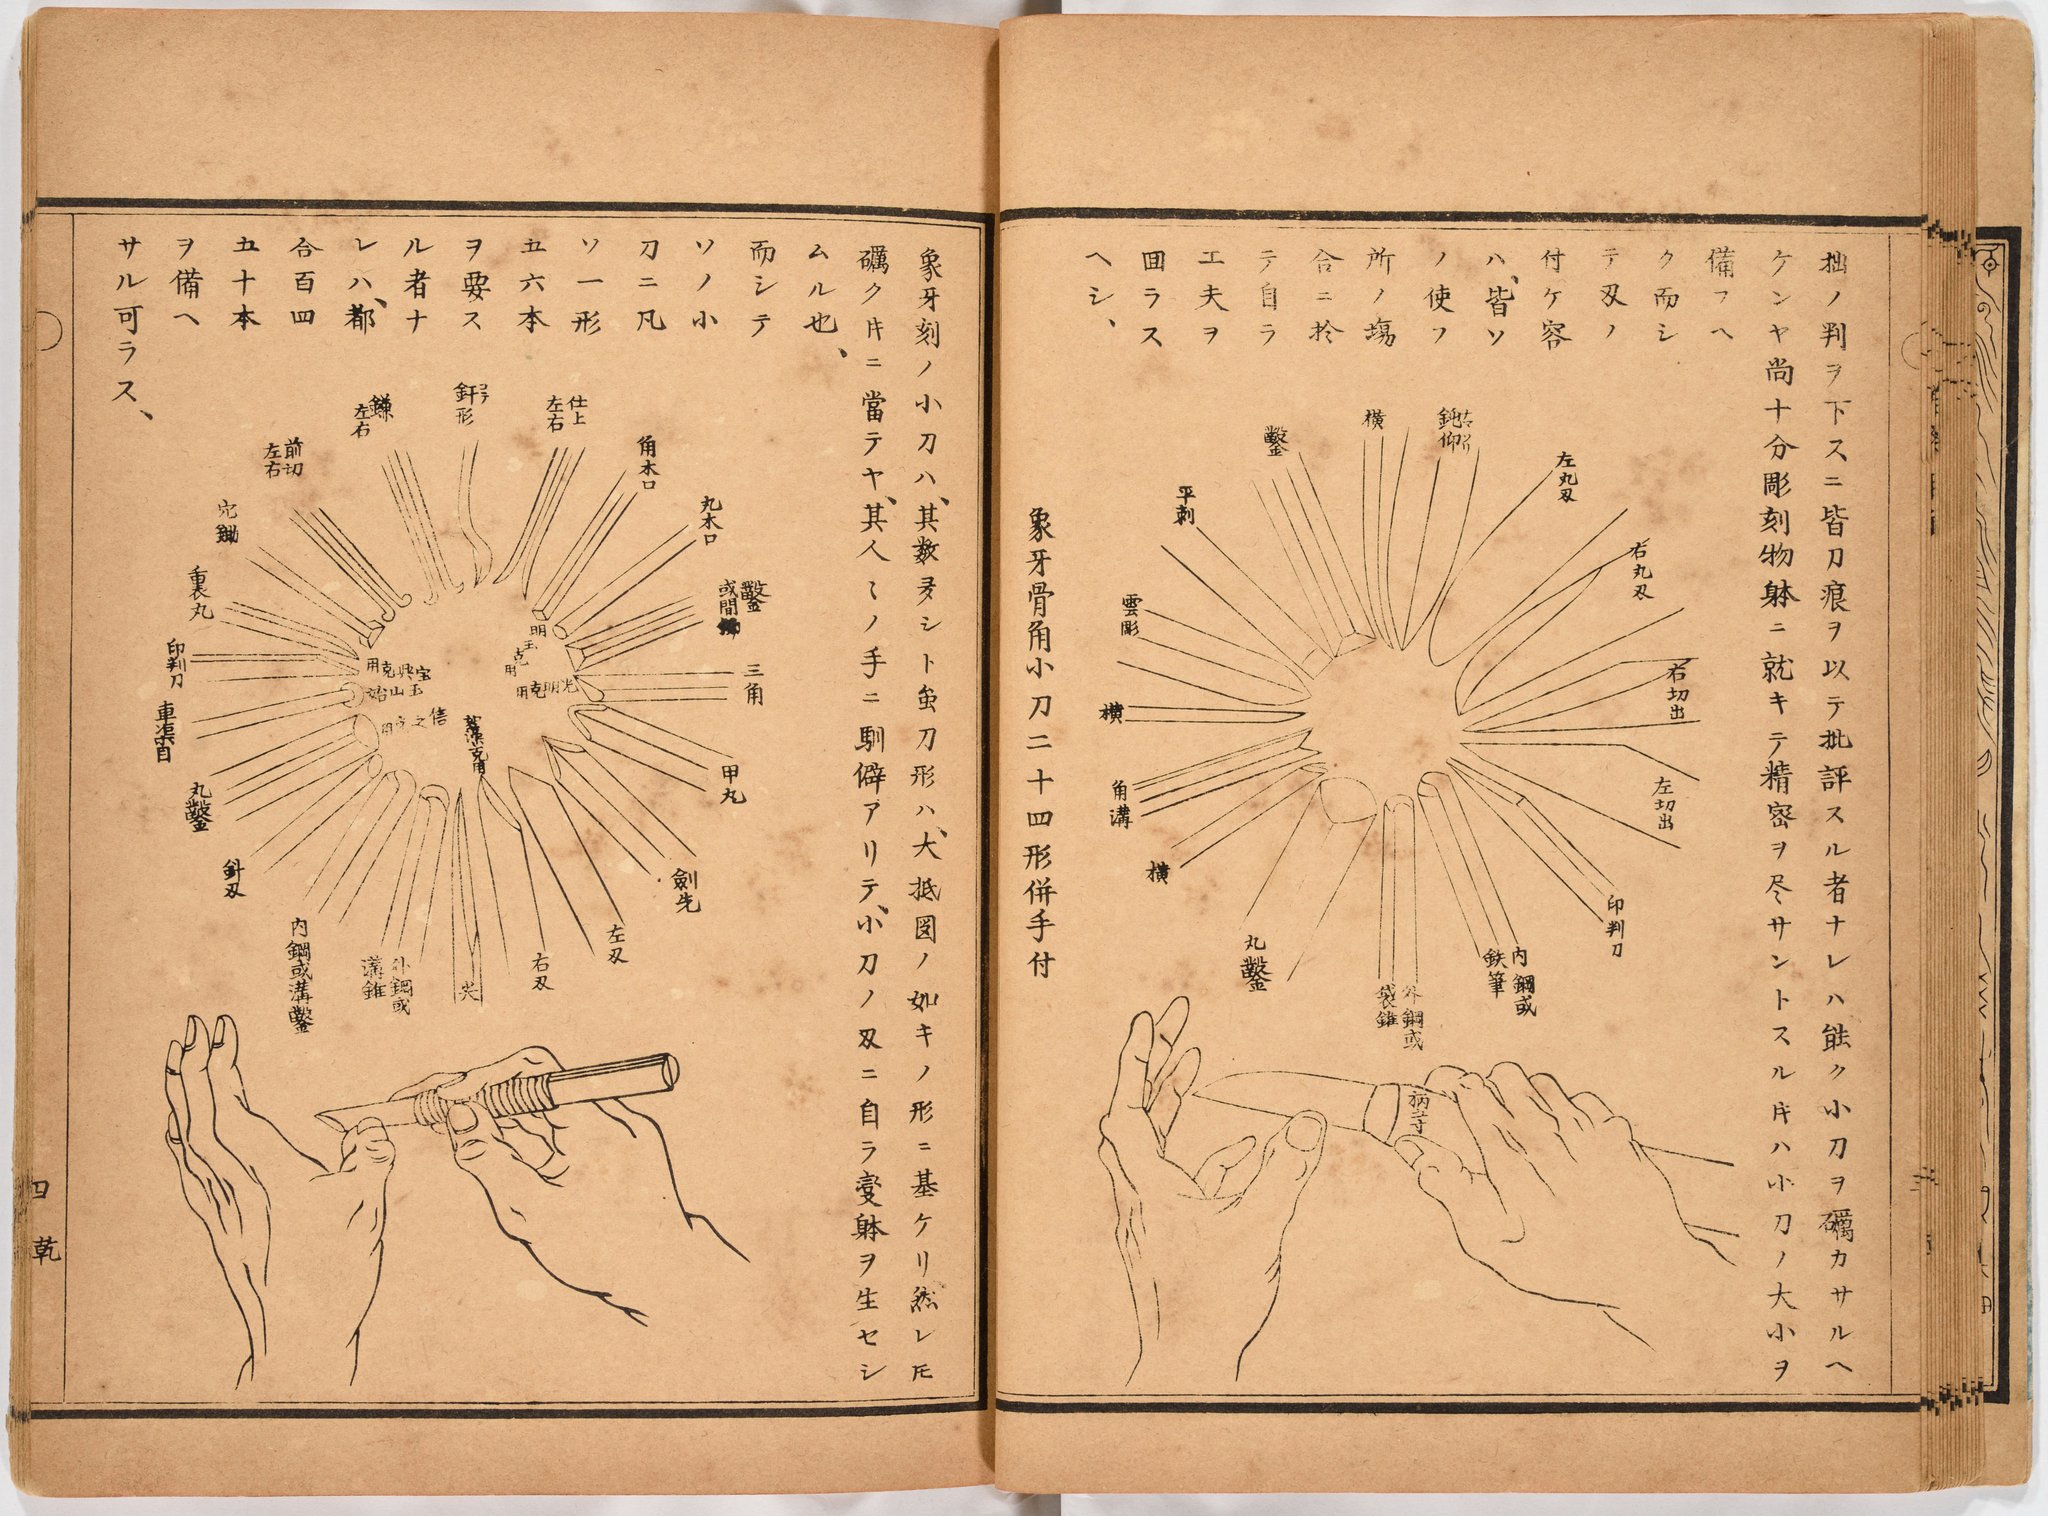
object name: illustrated book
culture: japanese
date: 1893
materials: ink, paper